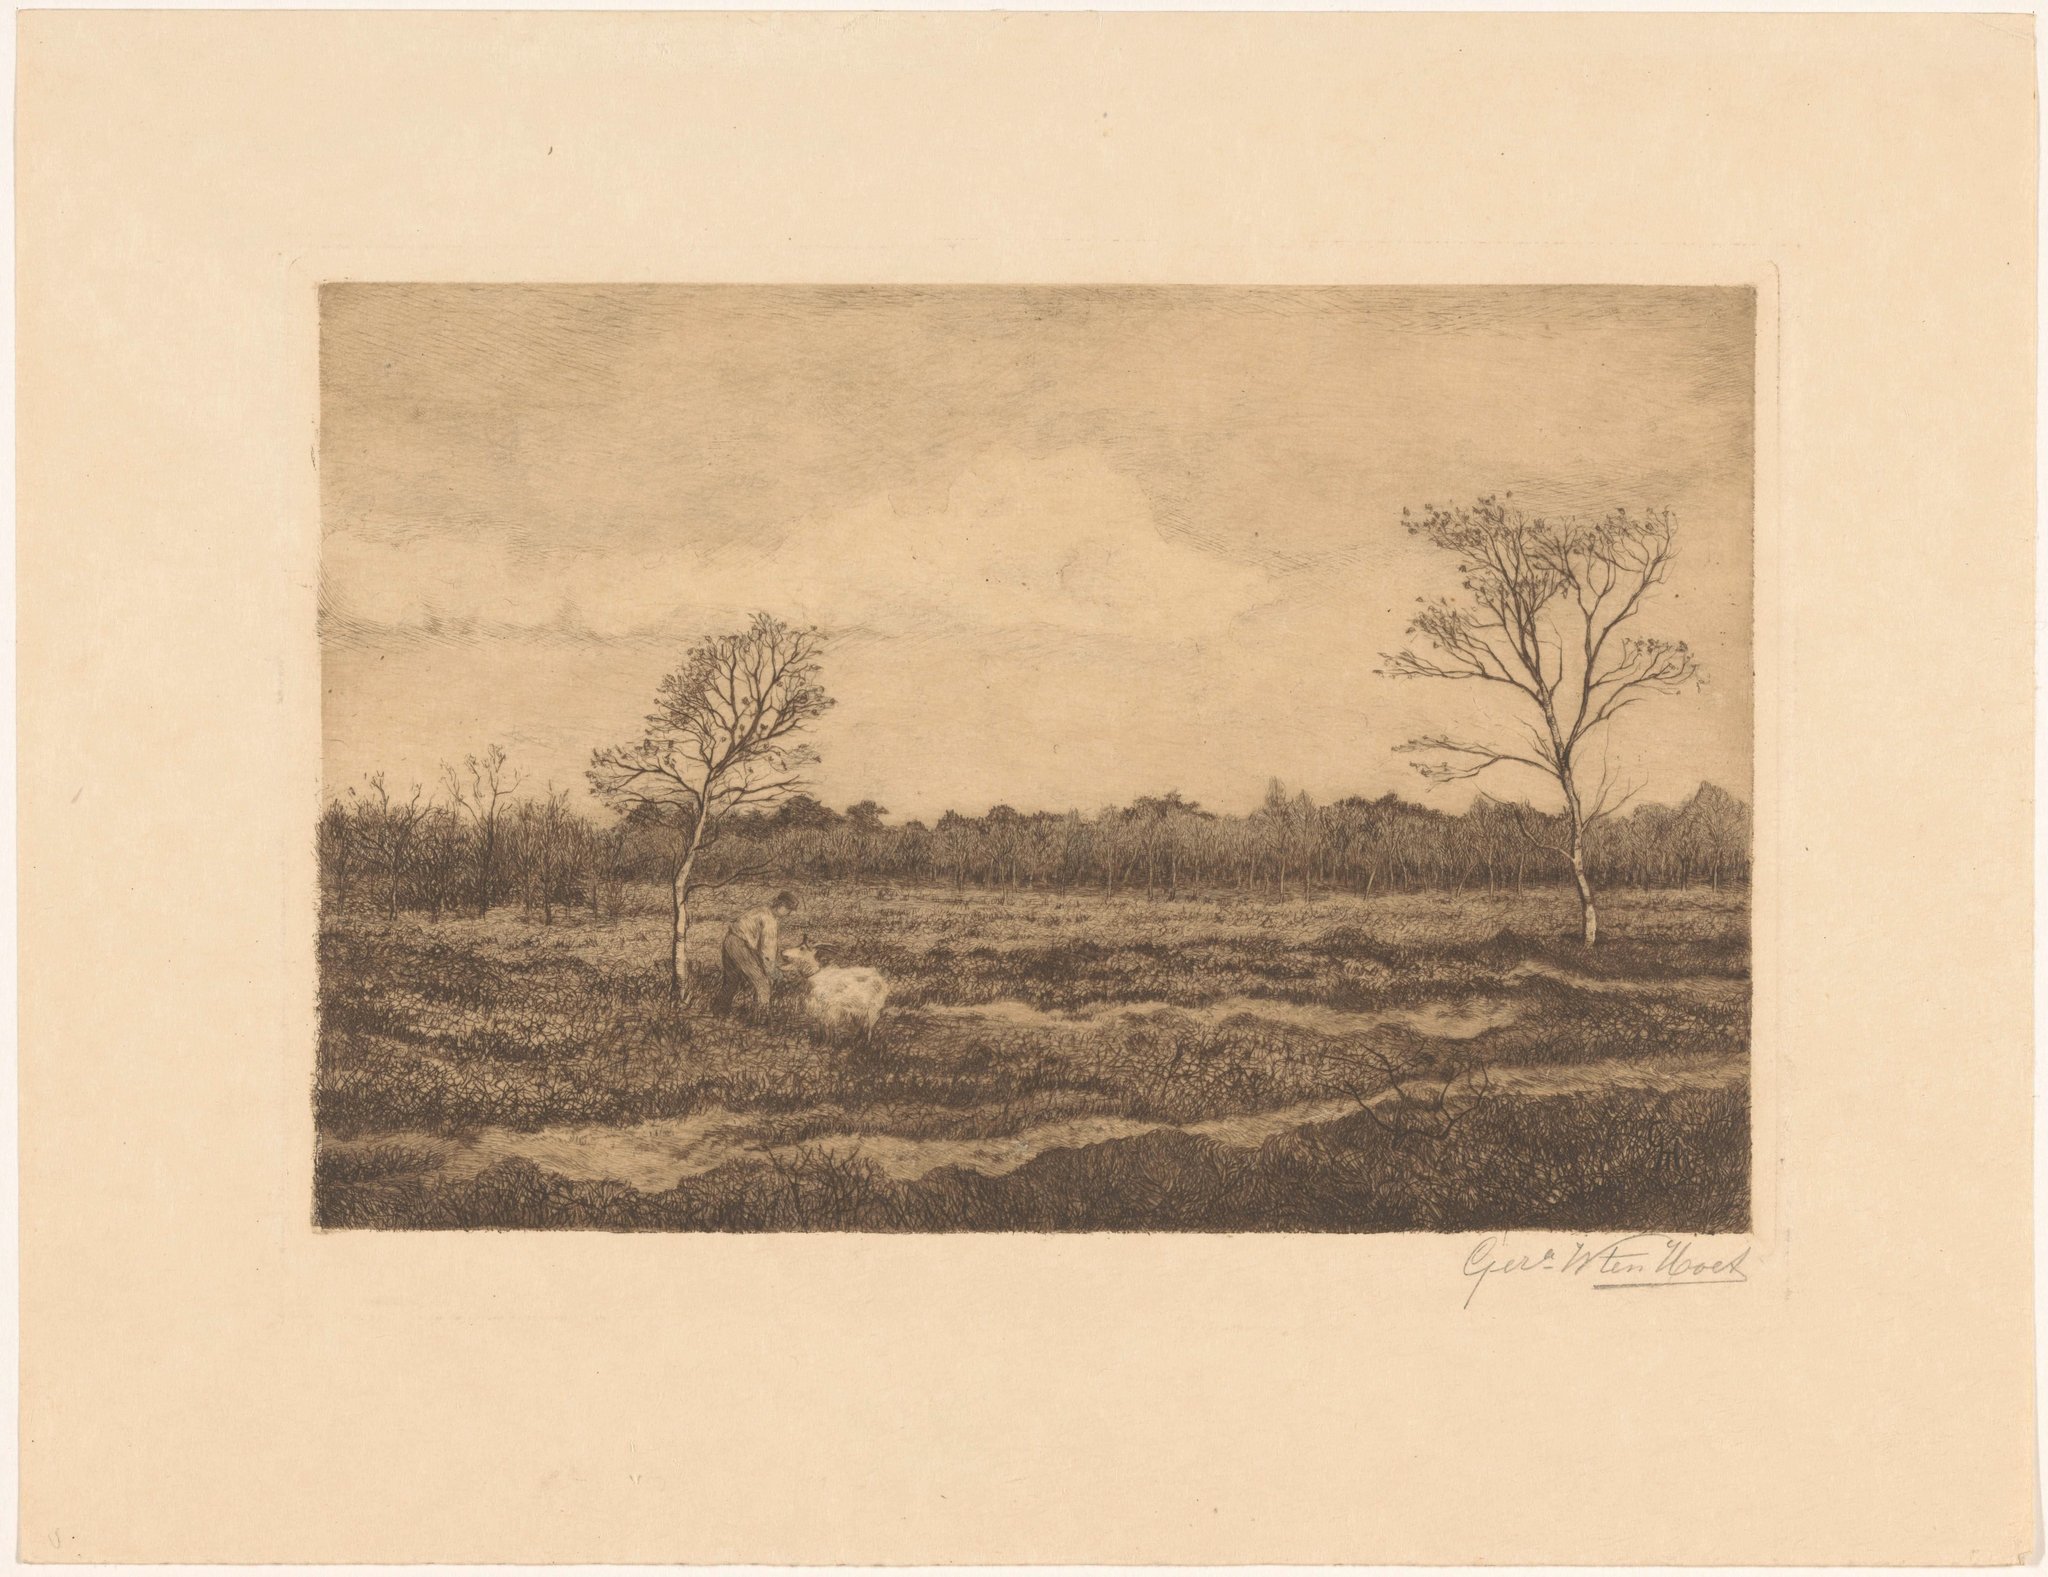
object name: print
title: Landschap met man en geit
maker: gerarda wilhelmina ten hoet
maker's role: print maker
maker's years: 1857-1939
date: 1867-1939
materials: paper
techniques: etching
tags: meadow, pasture, orchard, goat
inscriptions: collector's mark: Lugt 2228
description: In het midden staat een man met een geit. Op de achtergrond een boomgaard.